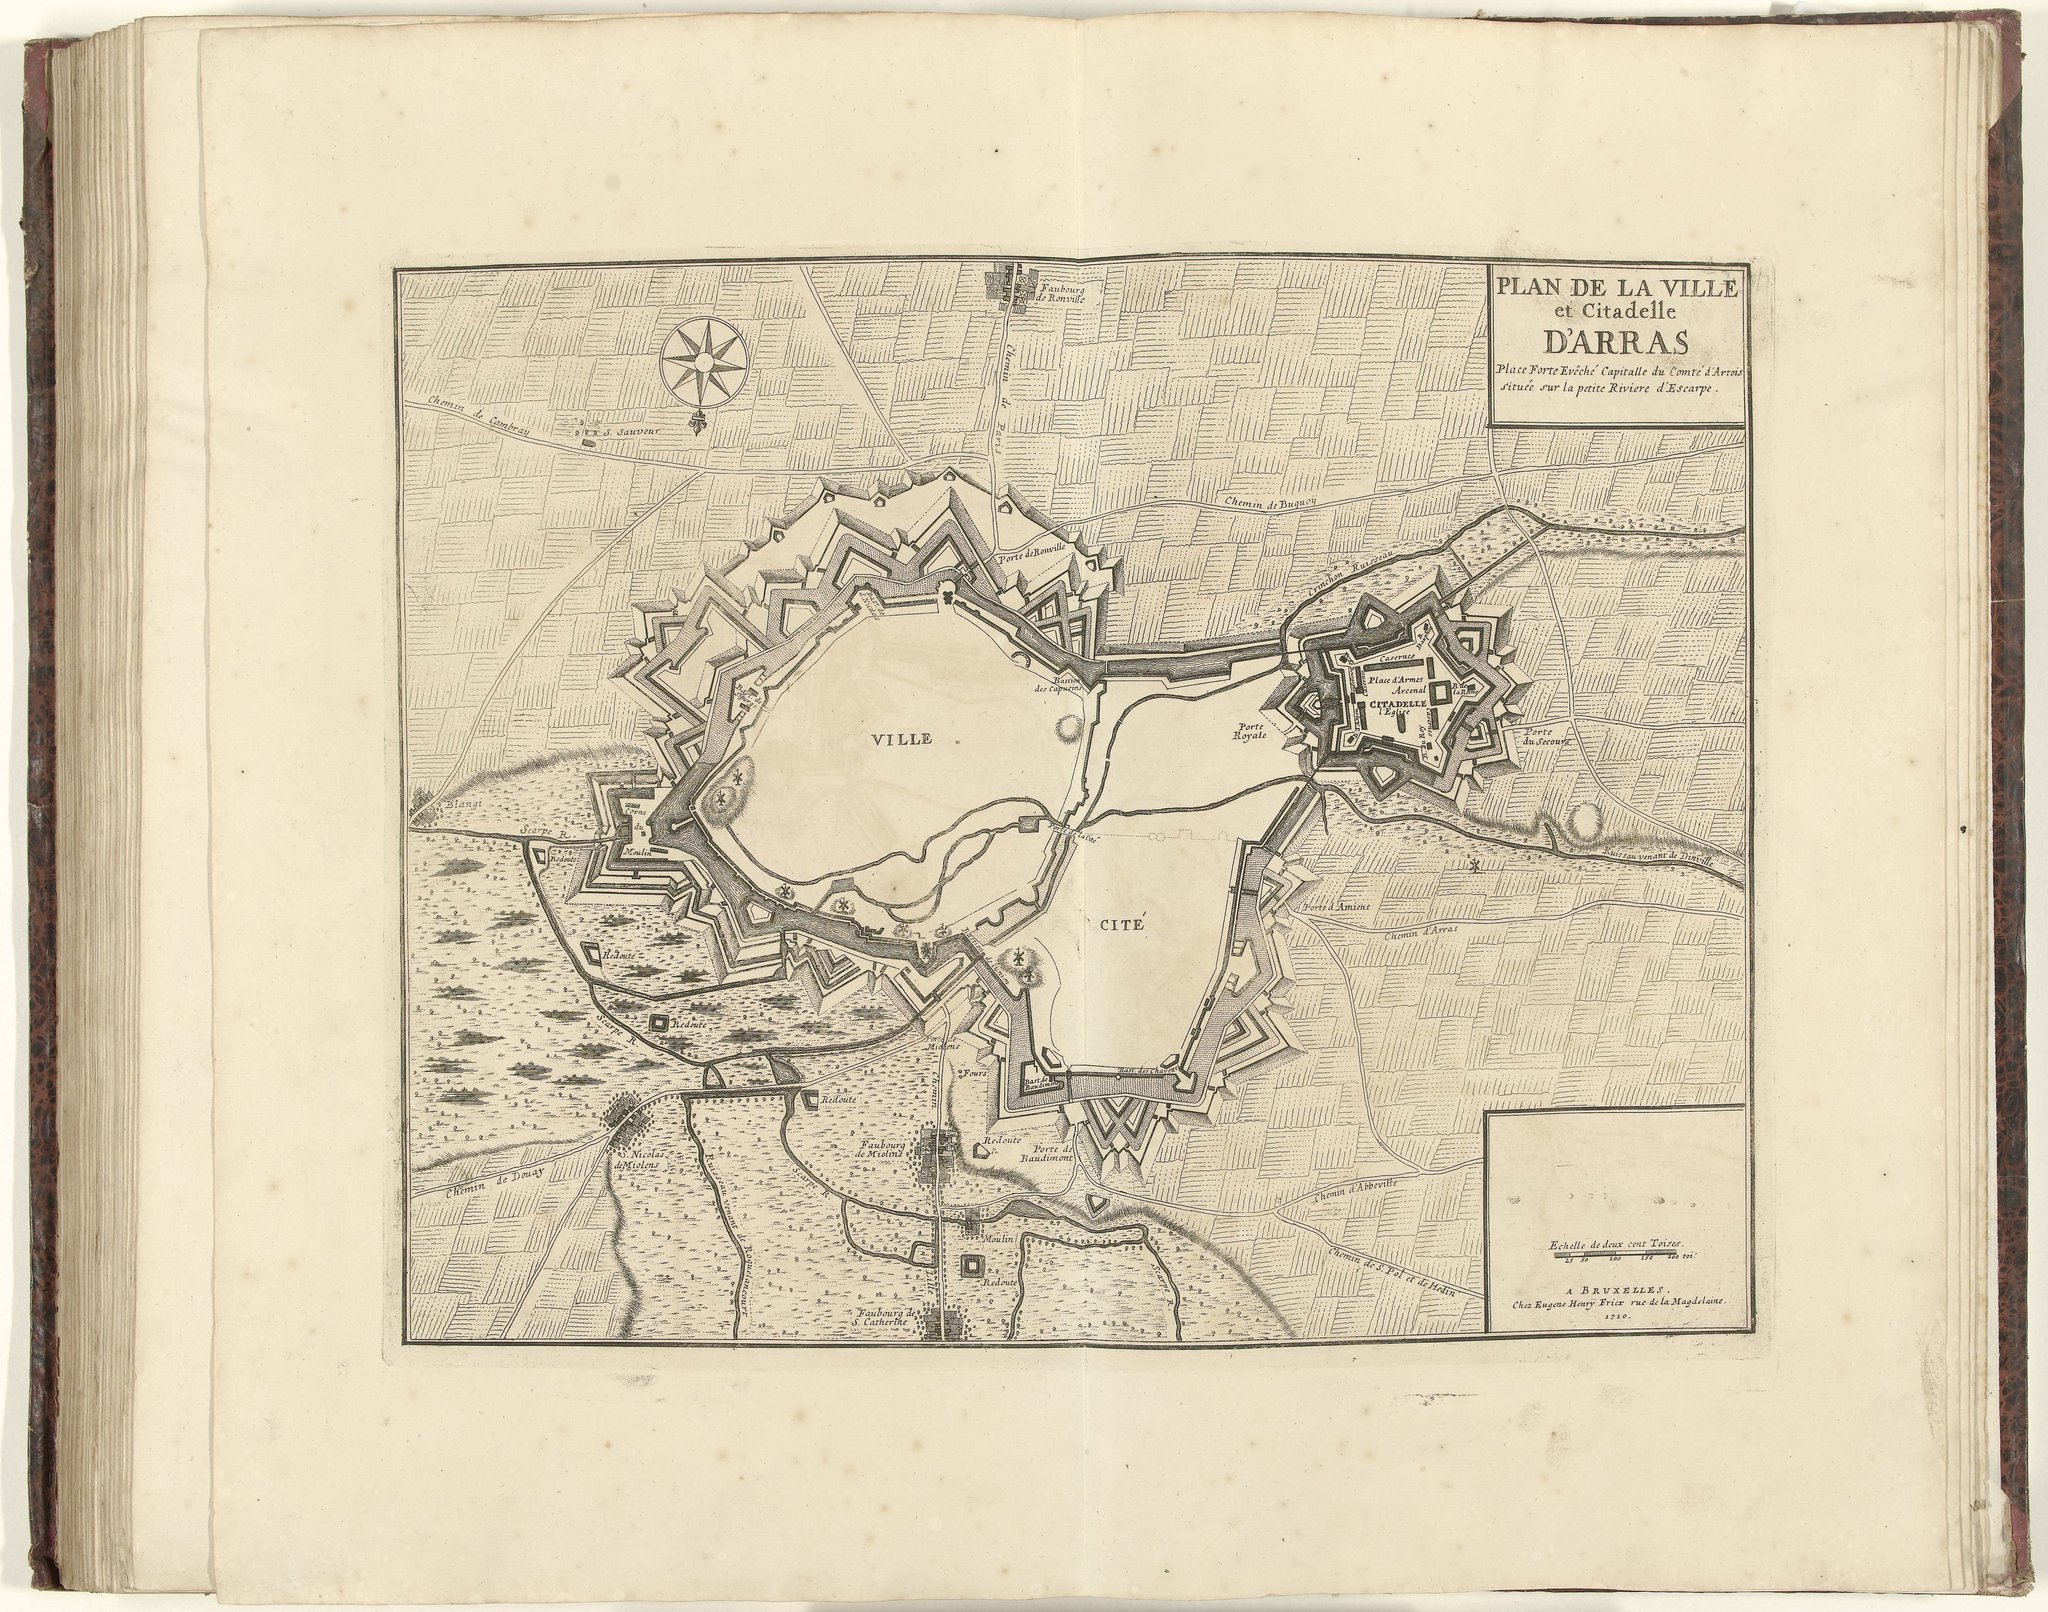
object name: print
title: Plan de la Ville et Citadelle d'Arras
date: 1710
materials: paper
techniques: etching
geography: brussels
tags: maps of cities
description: Plattegrond van Arras, 1710. Onderdeel van een gebundelde verzameling van plannen van veldslagen en steden vermaard in de Spaanse Successieoorlog.